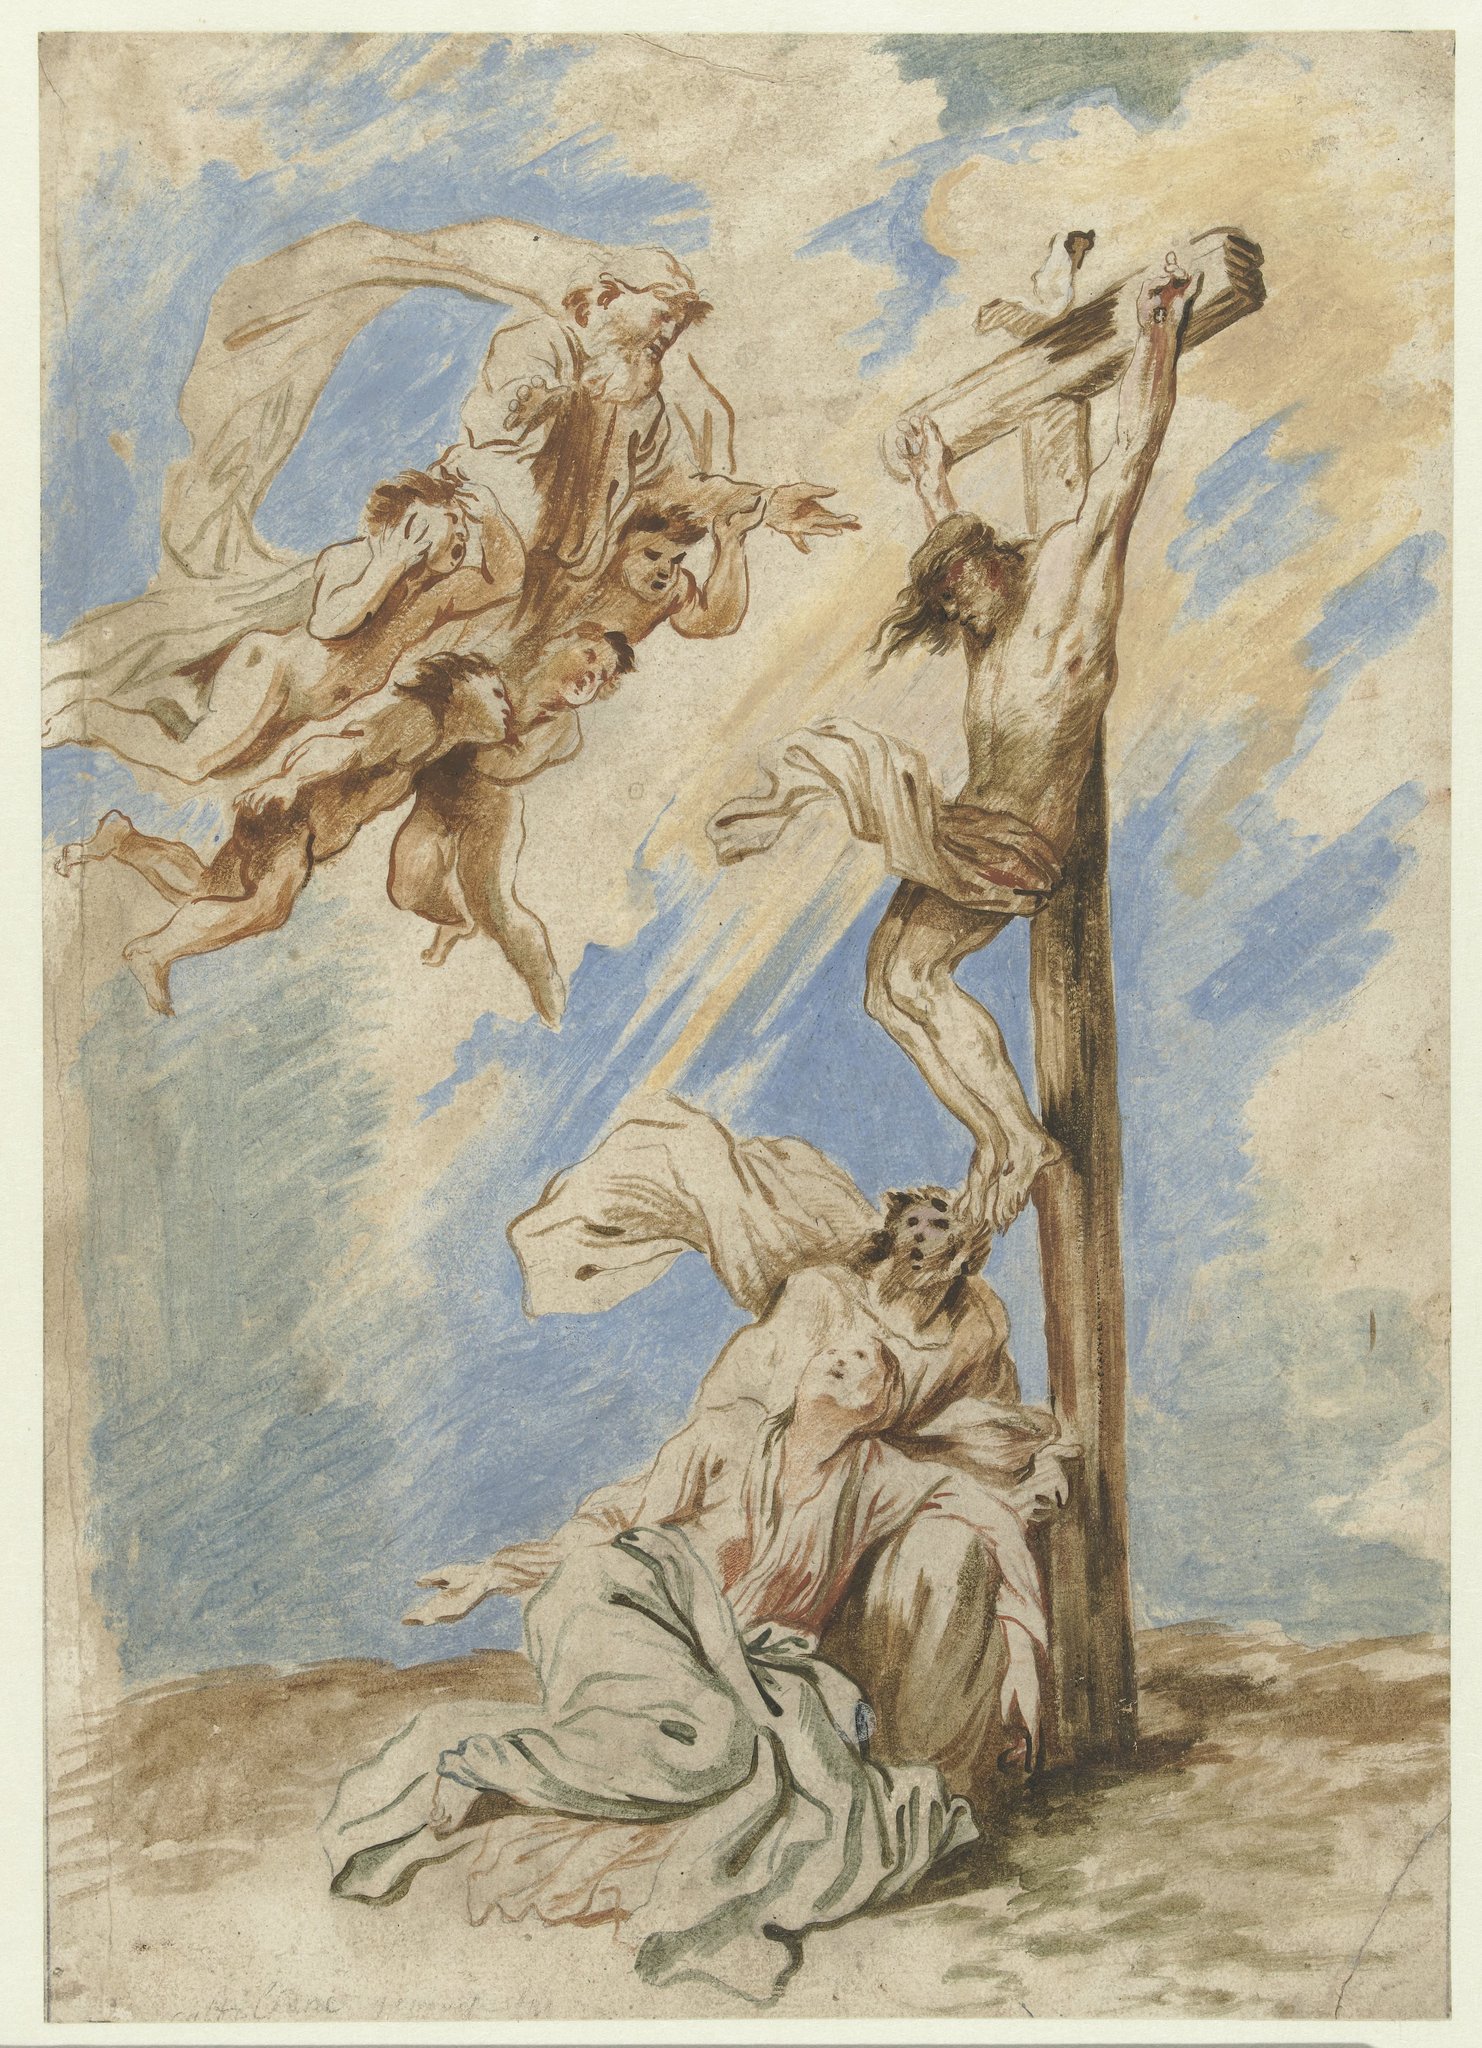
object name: drawing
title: Christ on the Cross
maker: giovanni benedetto castiglione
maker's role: draughtsman, print maker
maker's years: 1610-1665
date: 1650-1659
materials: oil, paper, pencil, watercolor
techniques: brush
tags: 73d6411(+11)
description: Unlike most Italian artists, Castiglione was strongly influenced by foreign art. In his hometown of Genoa he came into contact with the work of Peter Paul Rubens. He also spent some time there in the studio of Anthony van Dyck. That Flemish influence is clearly reflected in this drawing: the striking use of colour and the animated composition recall oil sketches by Rubens and Van Dyck.